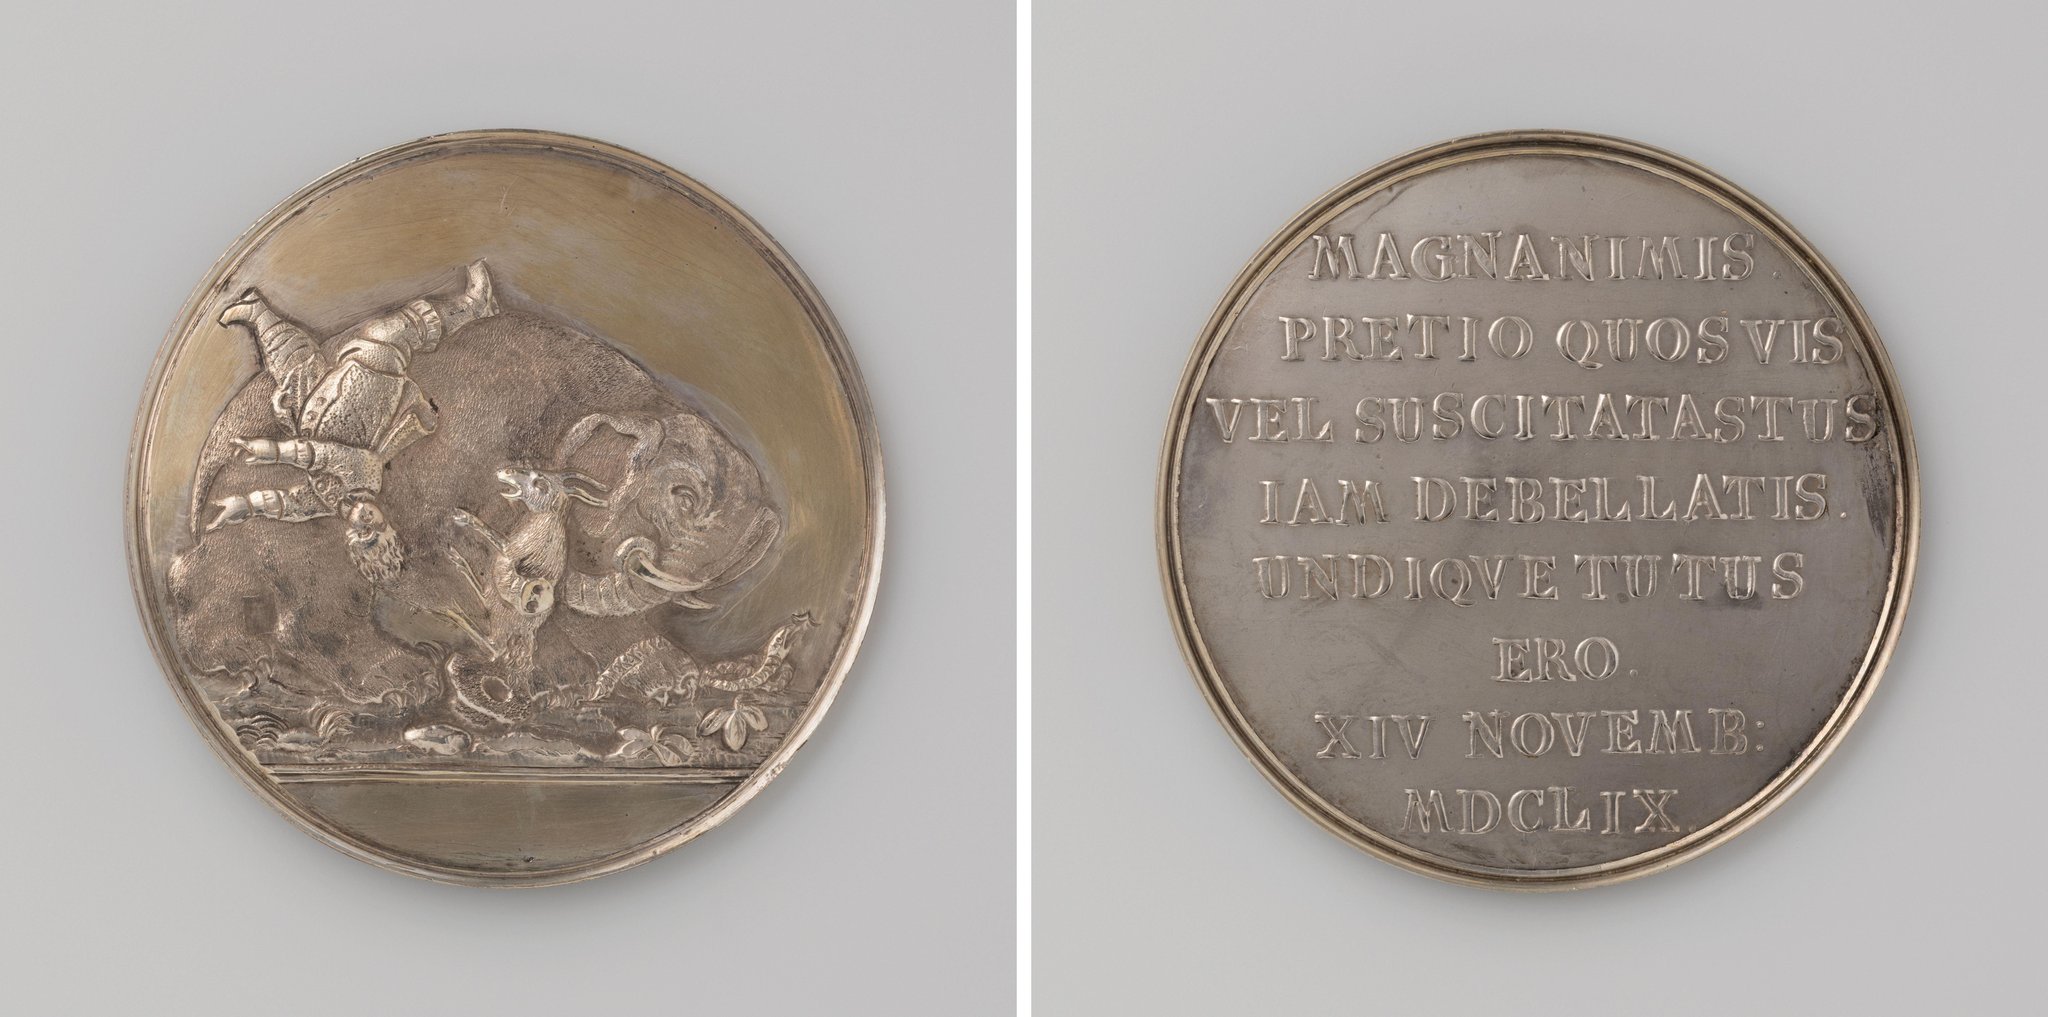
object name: history medal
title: Overwinning op de Zweden op Funen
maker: Anonymous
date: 1659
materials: silver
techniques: striking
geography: denmark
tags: faeröer, funen, noordse oorlogen, slag op funen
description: Zilveren penning. Voorzijde: de Deense olifant werpt een Zweed van zijn rug, vertrapt een slang en schudt een steenbok leeg. Keerzijde: opschrift